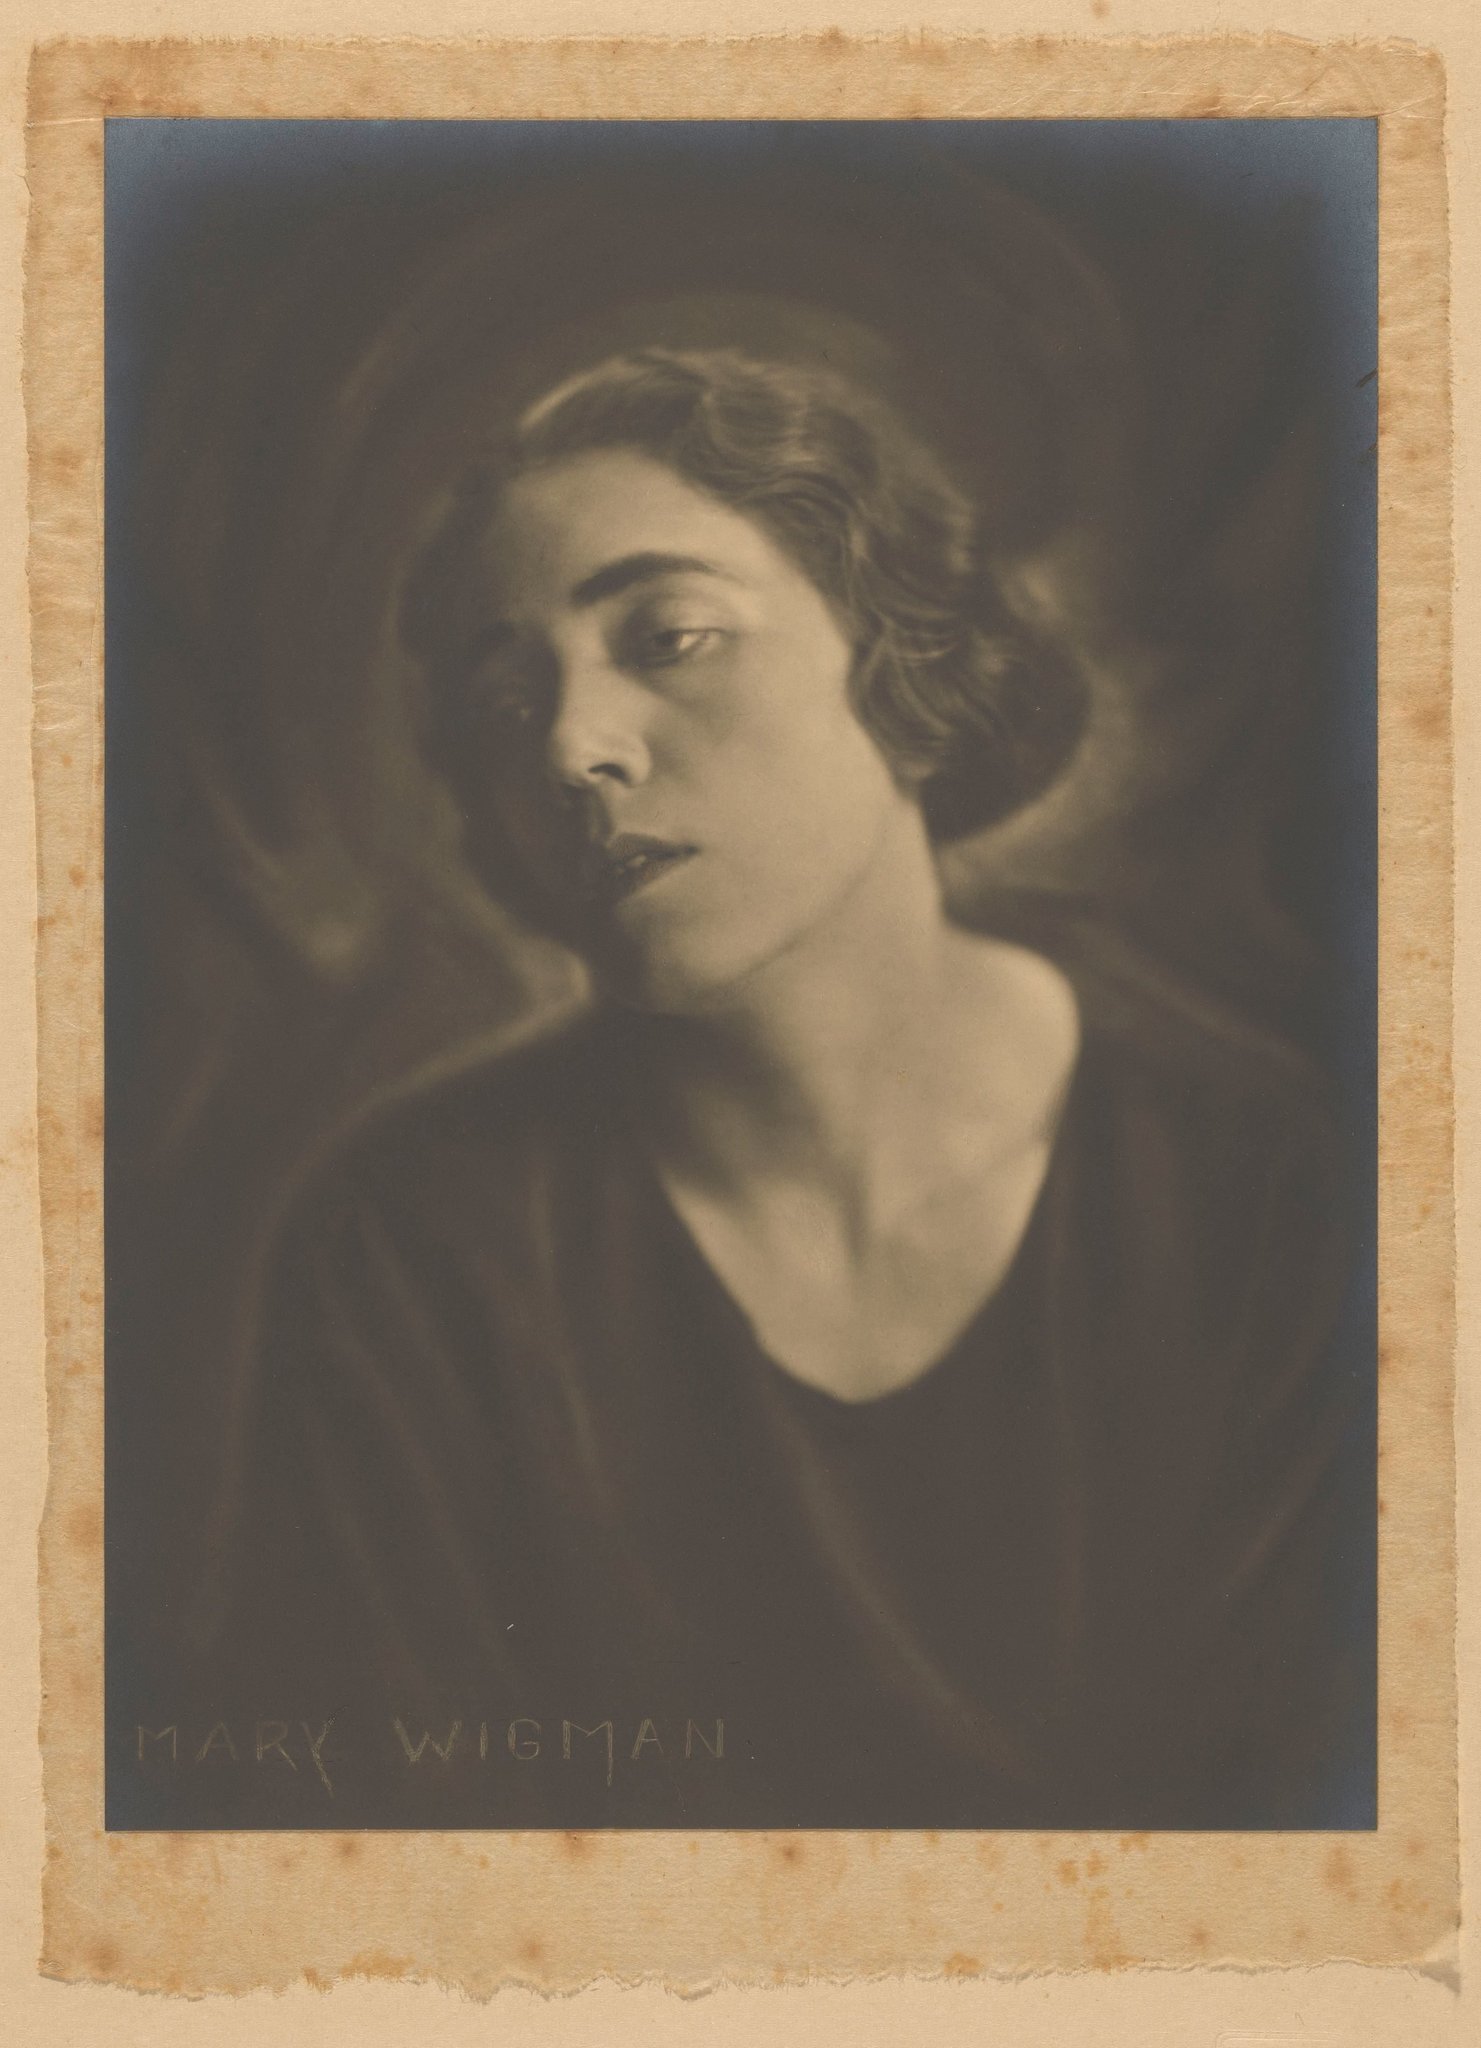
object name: photograph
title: Mary Wigman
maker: jacob merkelbach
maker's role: fotograaf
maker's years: 1877-1942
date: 1920-1930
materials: cardboard, paper, photographic support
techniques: gelatin silver print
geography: amsterdam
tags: historical persons (portraits and scenes from the life) - bb - woman